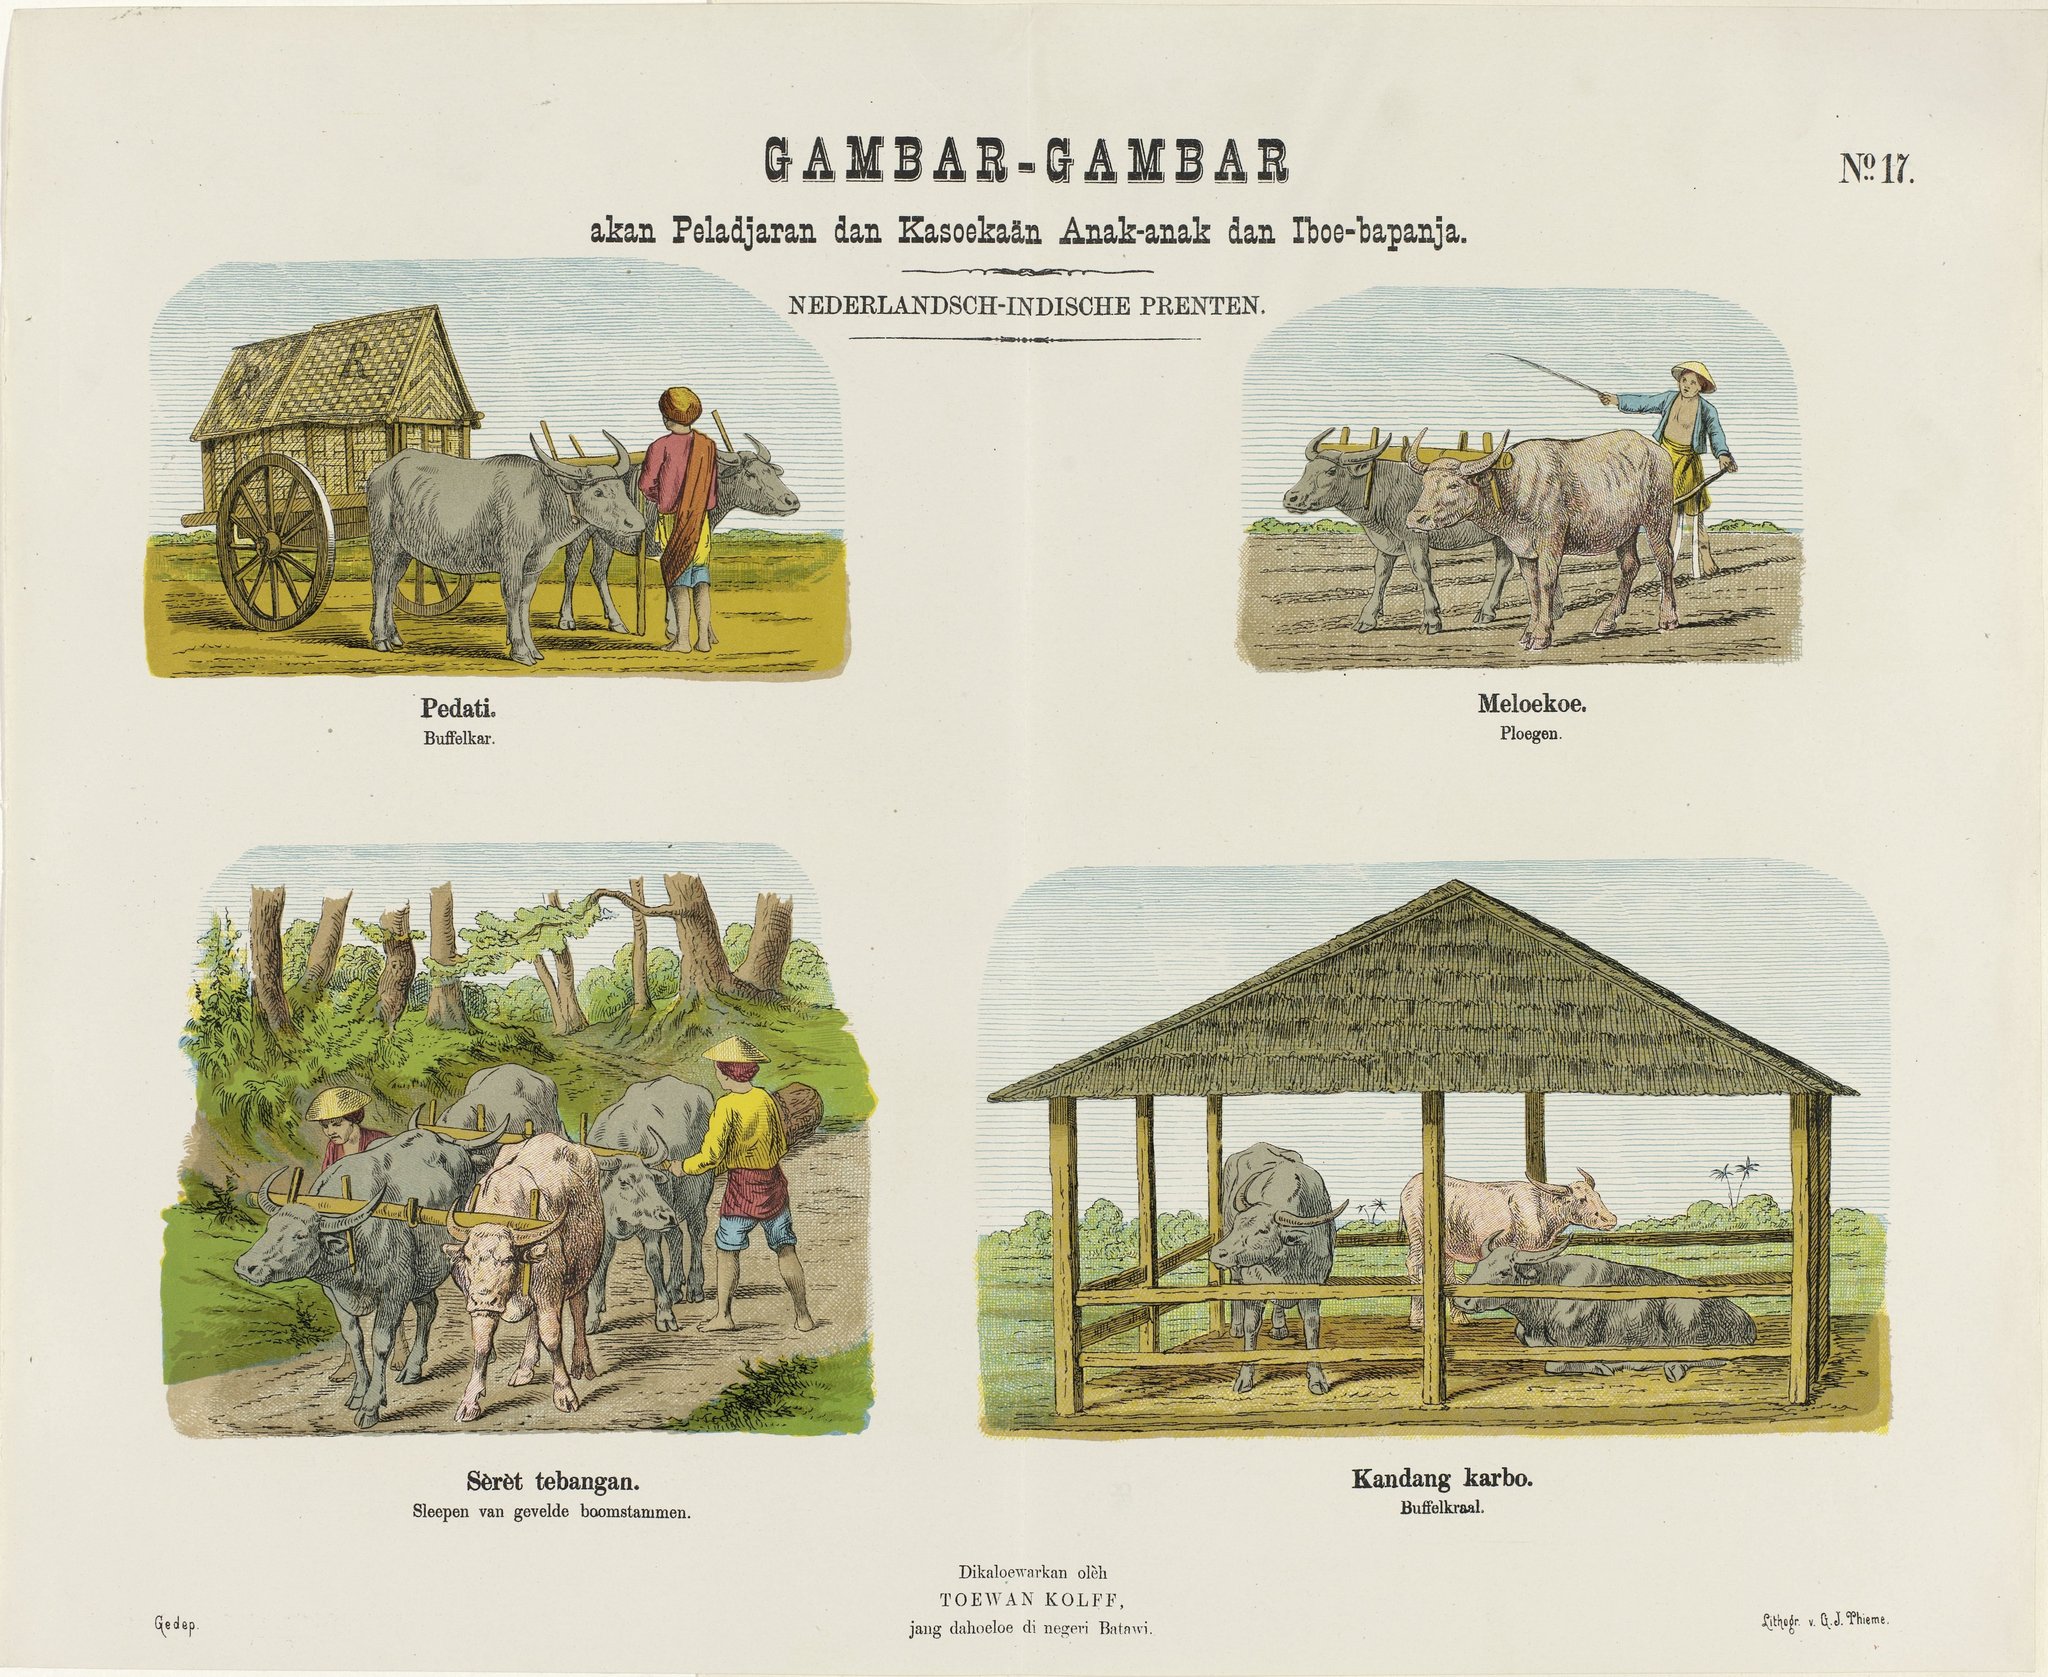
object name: print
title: Buffels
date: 1868-1881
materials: paper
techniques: lithograph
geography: leiden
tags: asiatic races and peoples, animals, dutch east indies, the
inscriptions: collector's mark: Lugt 2760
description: Blad met vier voorstellingen van buffels in de voormalige kolonie Nederlands-Indië. Onder elke afbeelding een onderschrift in het Maleis en het Nederlands. Genummerd rechtsboven: No. 17.